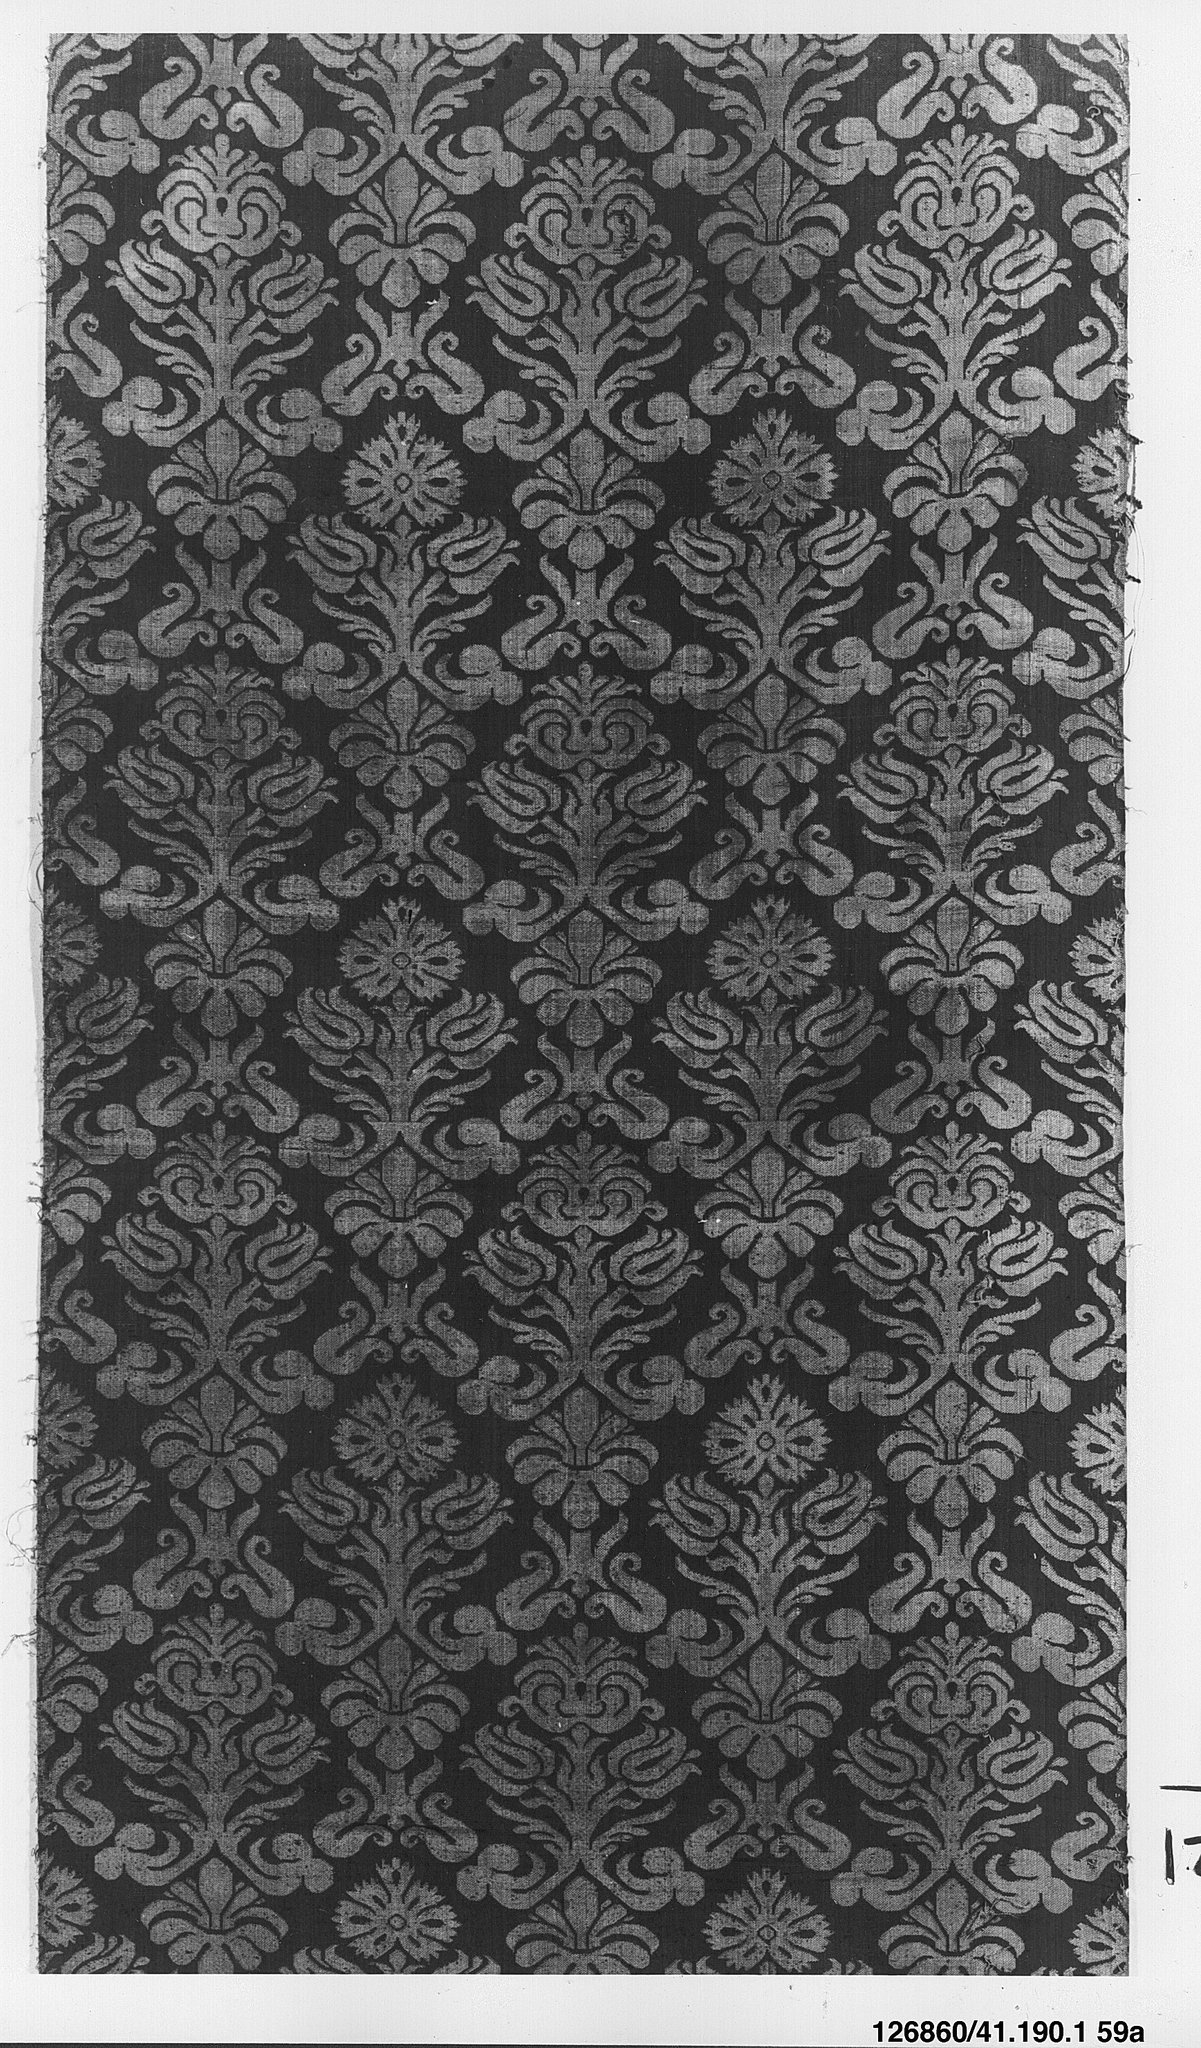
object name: strip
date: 1601-1633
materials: silk